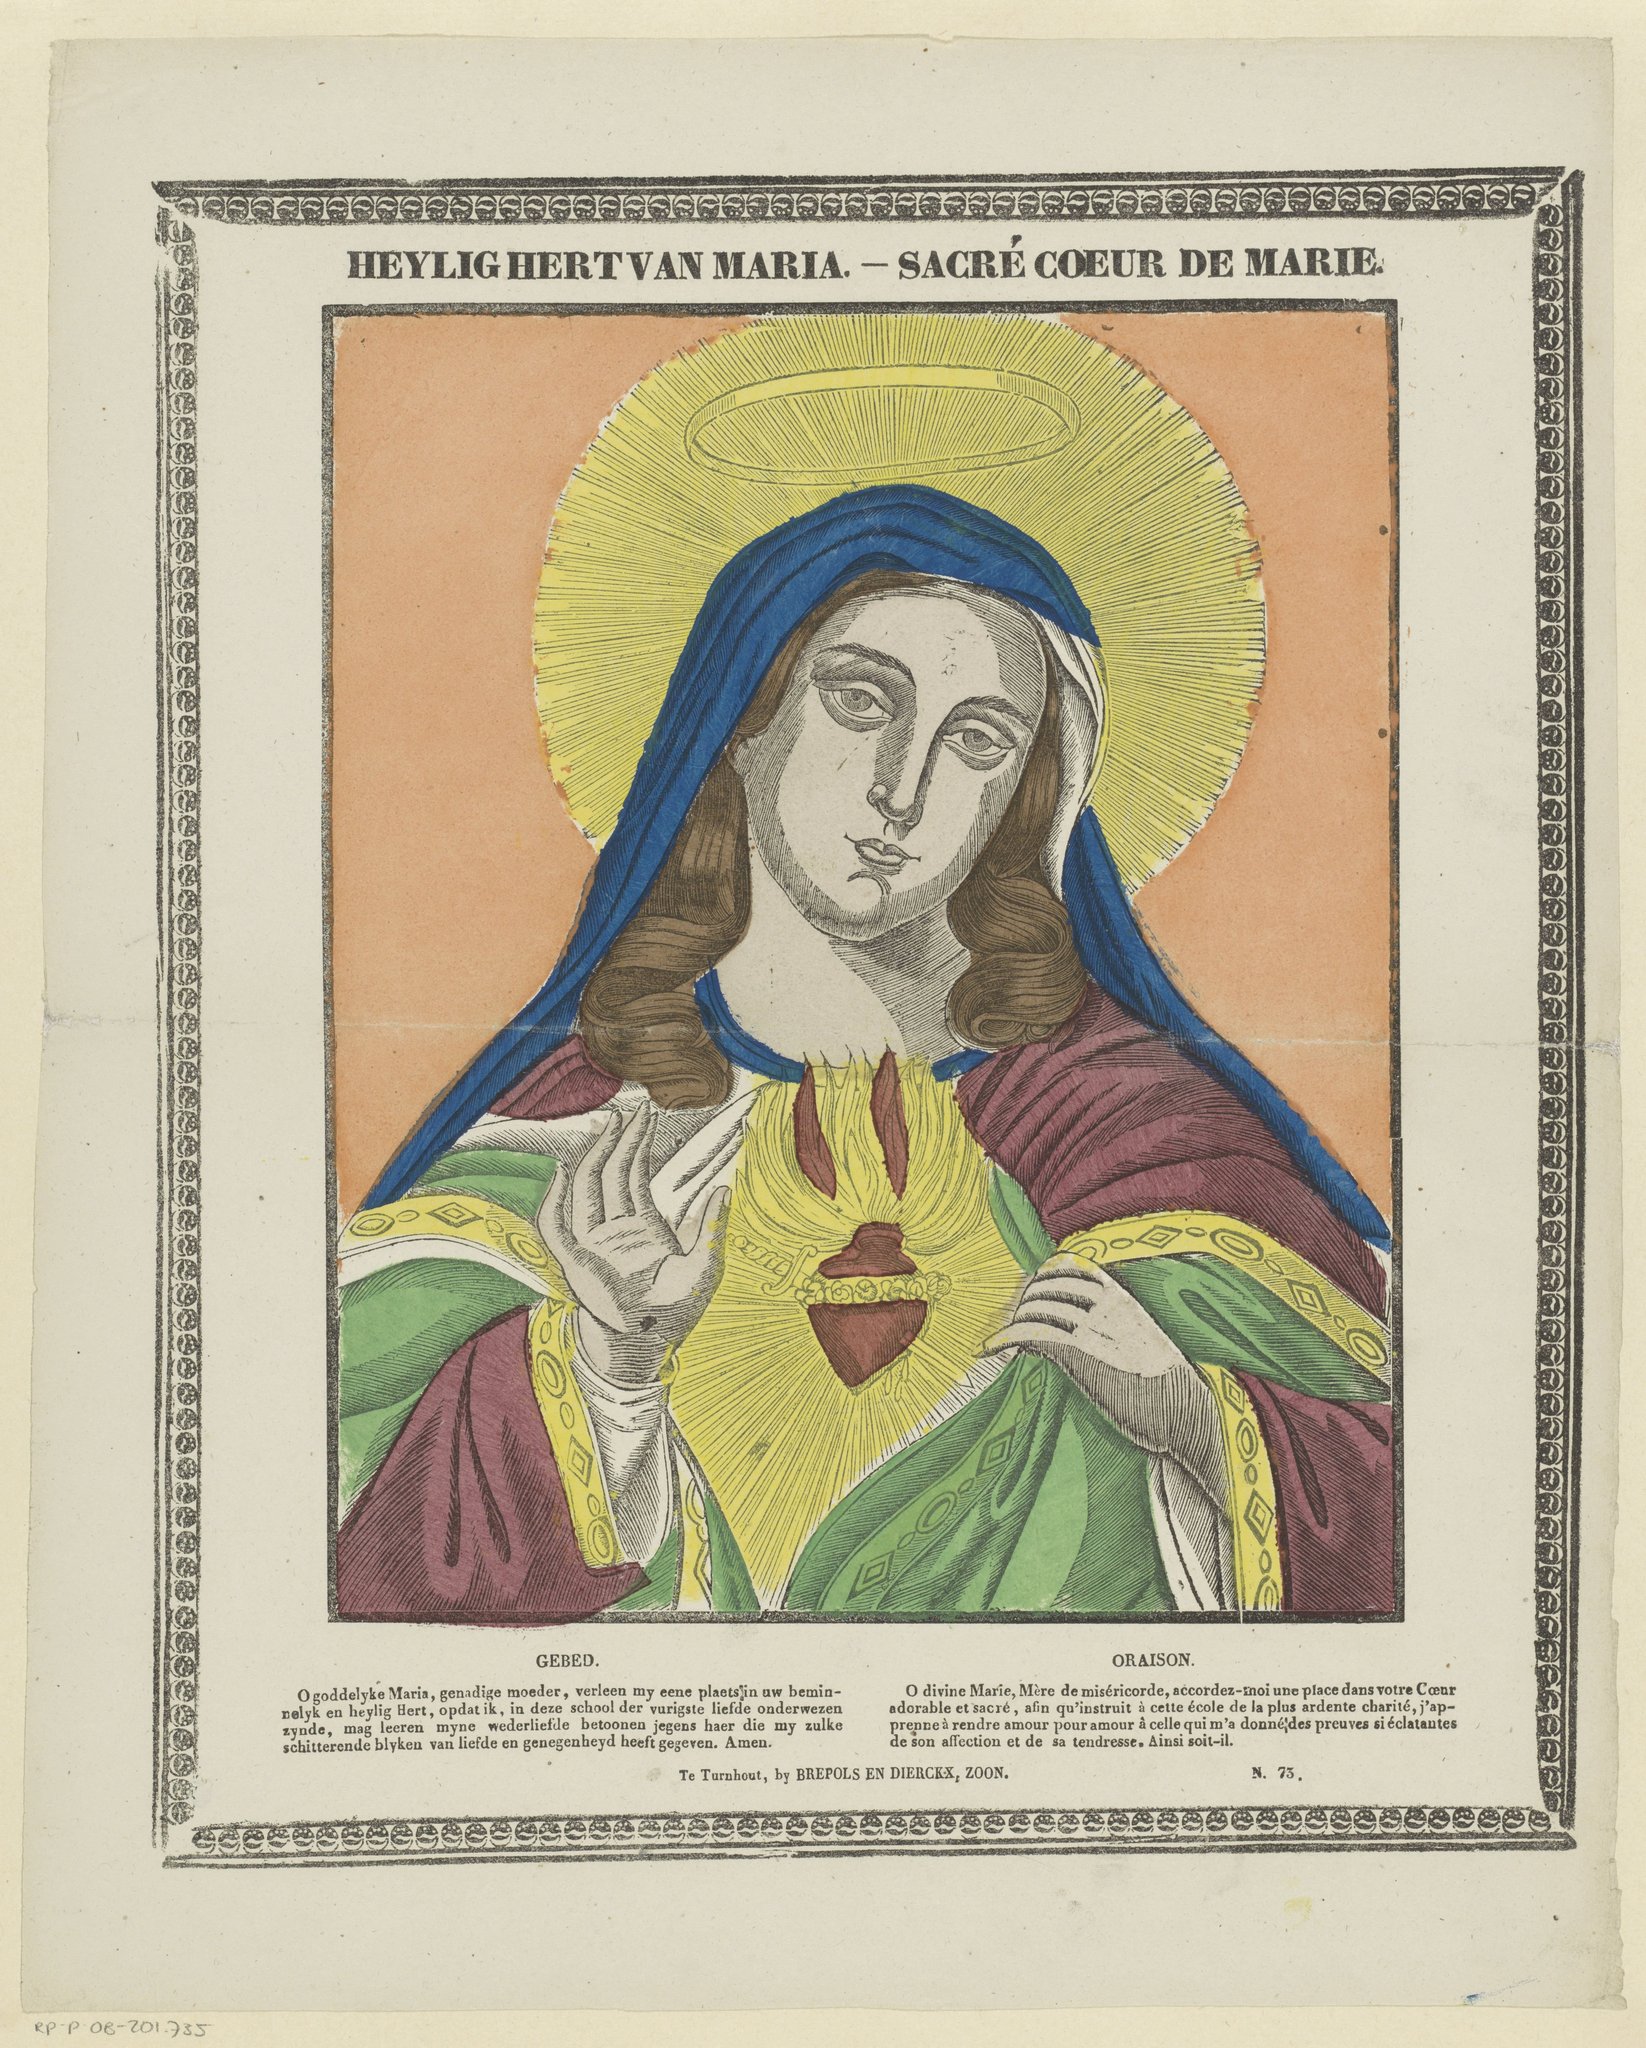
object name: print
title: Heylig hert van Maria / Sacré coeur de Marie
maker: Anonymous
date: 1833-1911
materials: paper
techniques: colour, letterpress printing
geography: turnhout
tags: the sacred heart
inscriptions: collector's mark: Lugt 2760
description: Maria met het heilige hart. Onderschrift in het Nederlands en in het Frans in twee kolommen. Geheel omgeven door sierrand. Genummerd rechtsonder: N. 73.